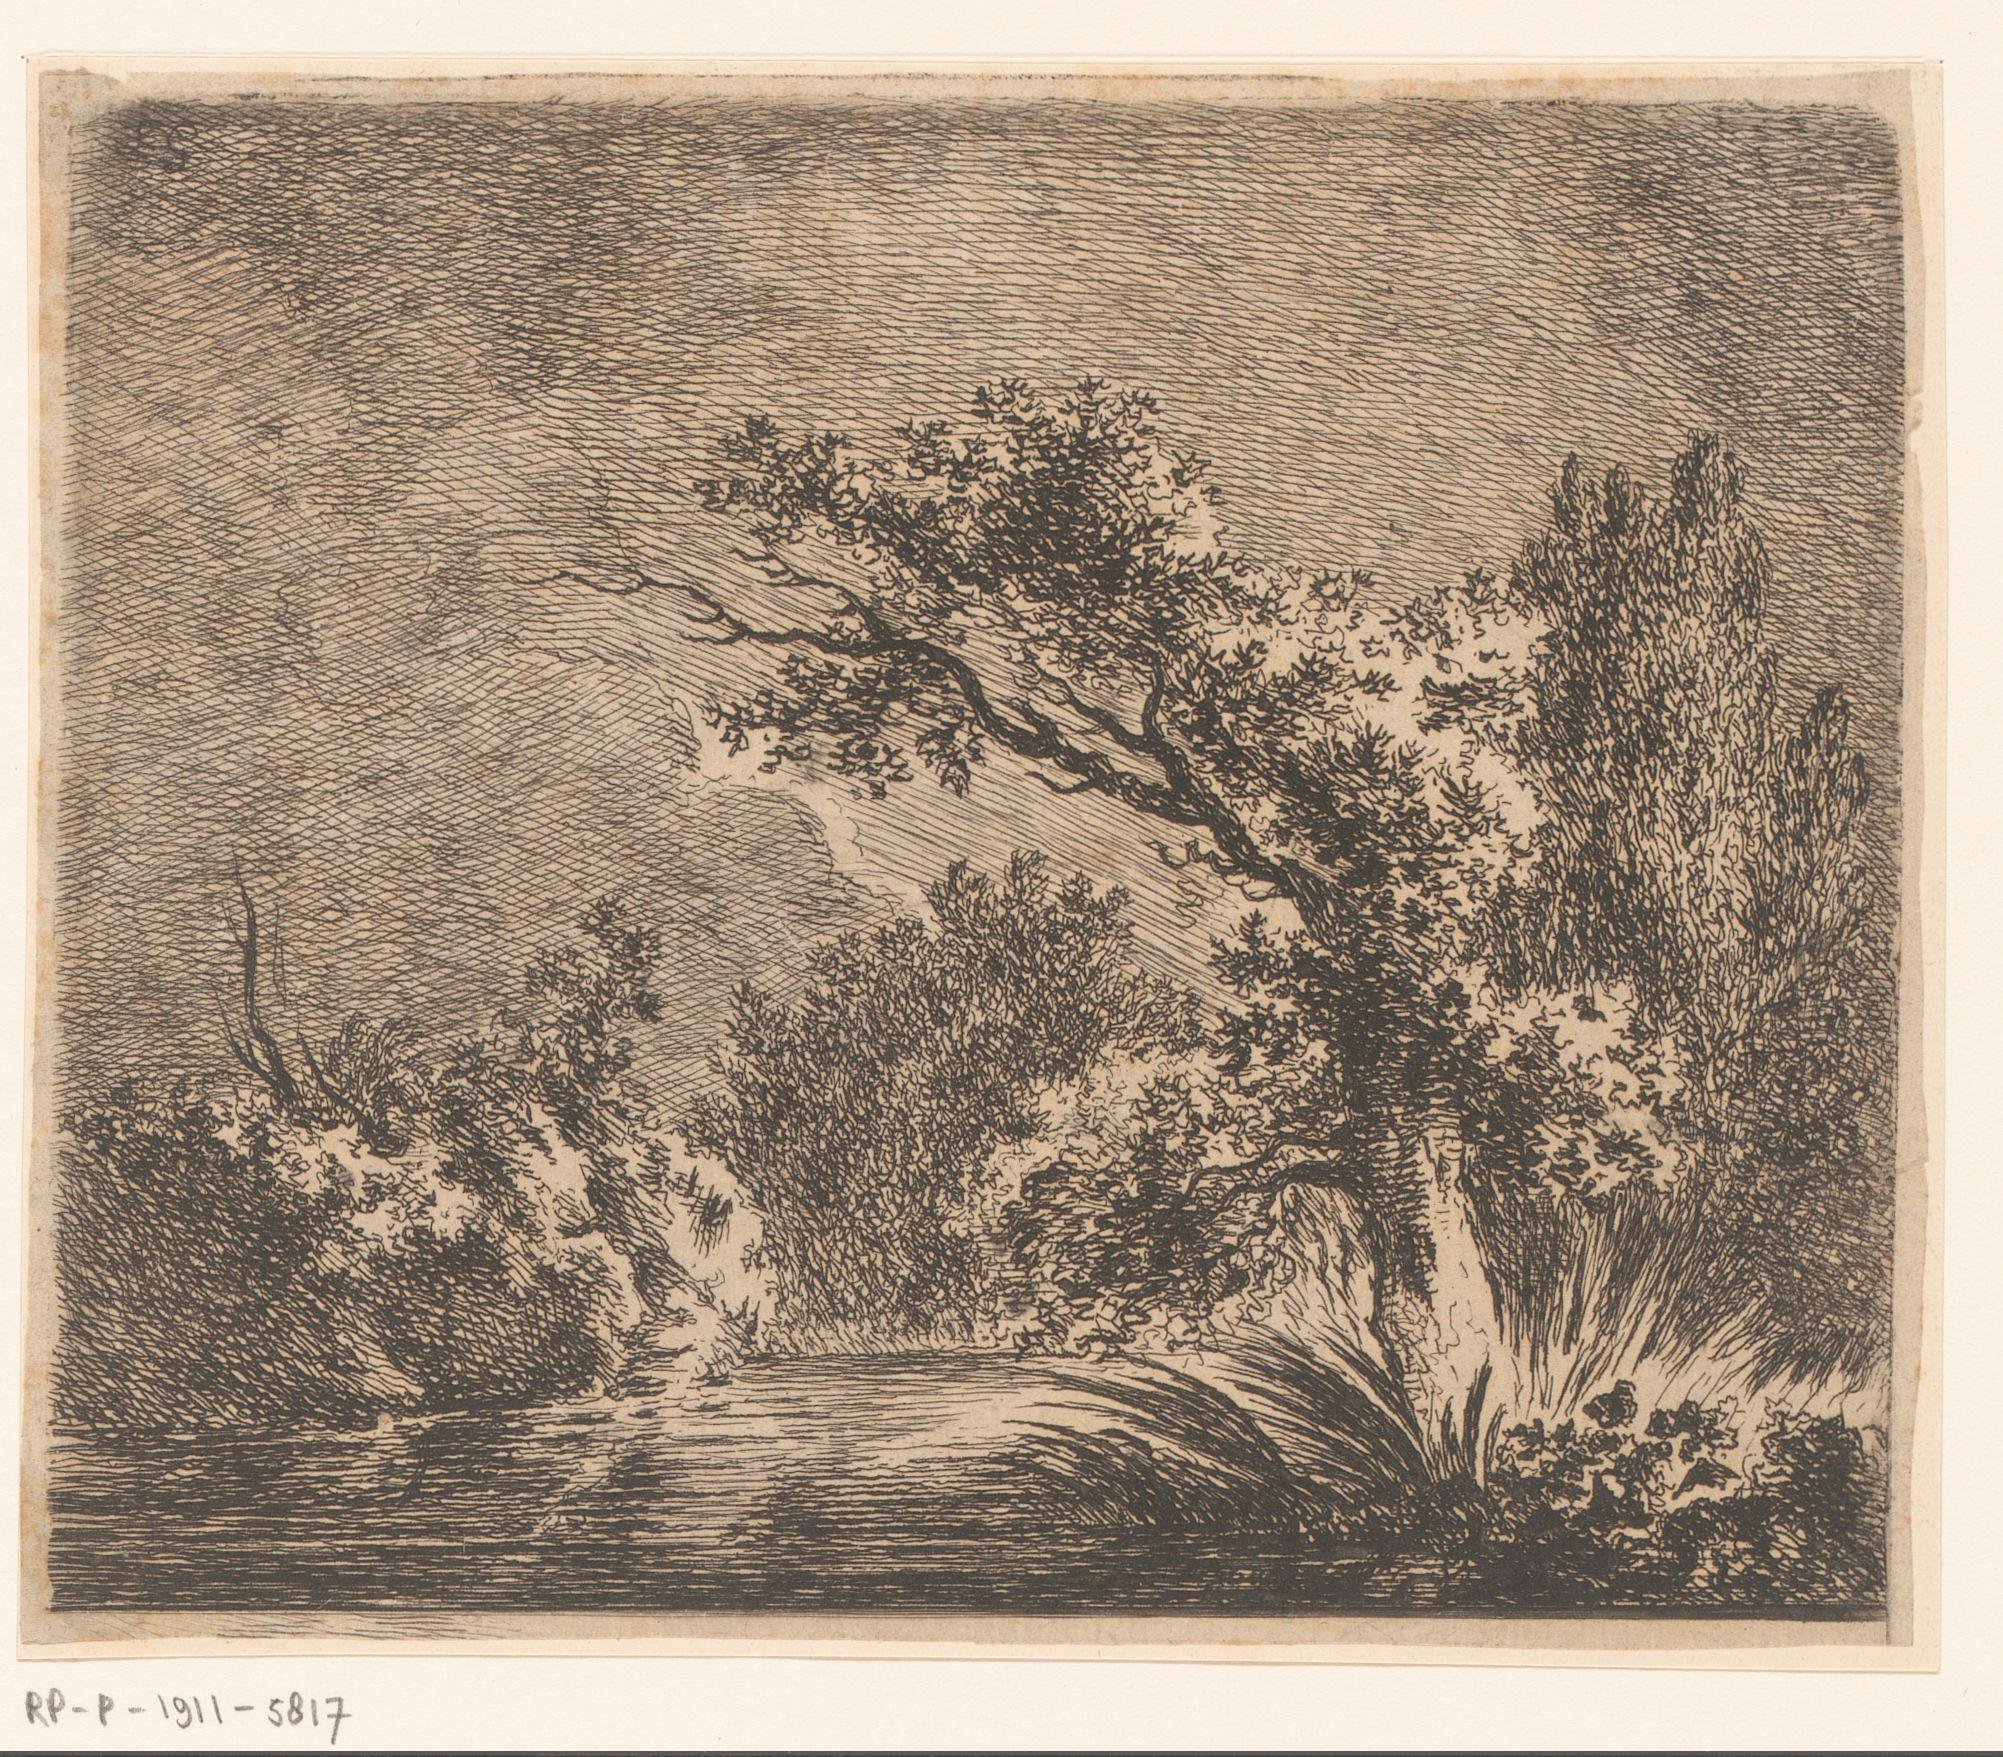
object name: print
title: Landschap met bomen aan het water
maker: sauveur legros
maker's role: print maker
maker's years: 1754-1834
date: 1764-1834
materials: paper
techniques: etching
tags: landscapes, swamps and polders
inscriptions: collector's mark: Lugt 2228